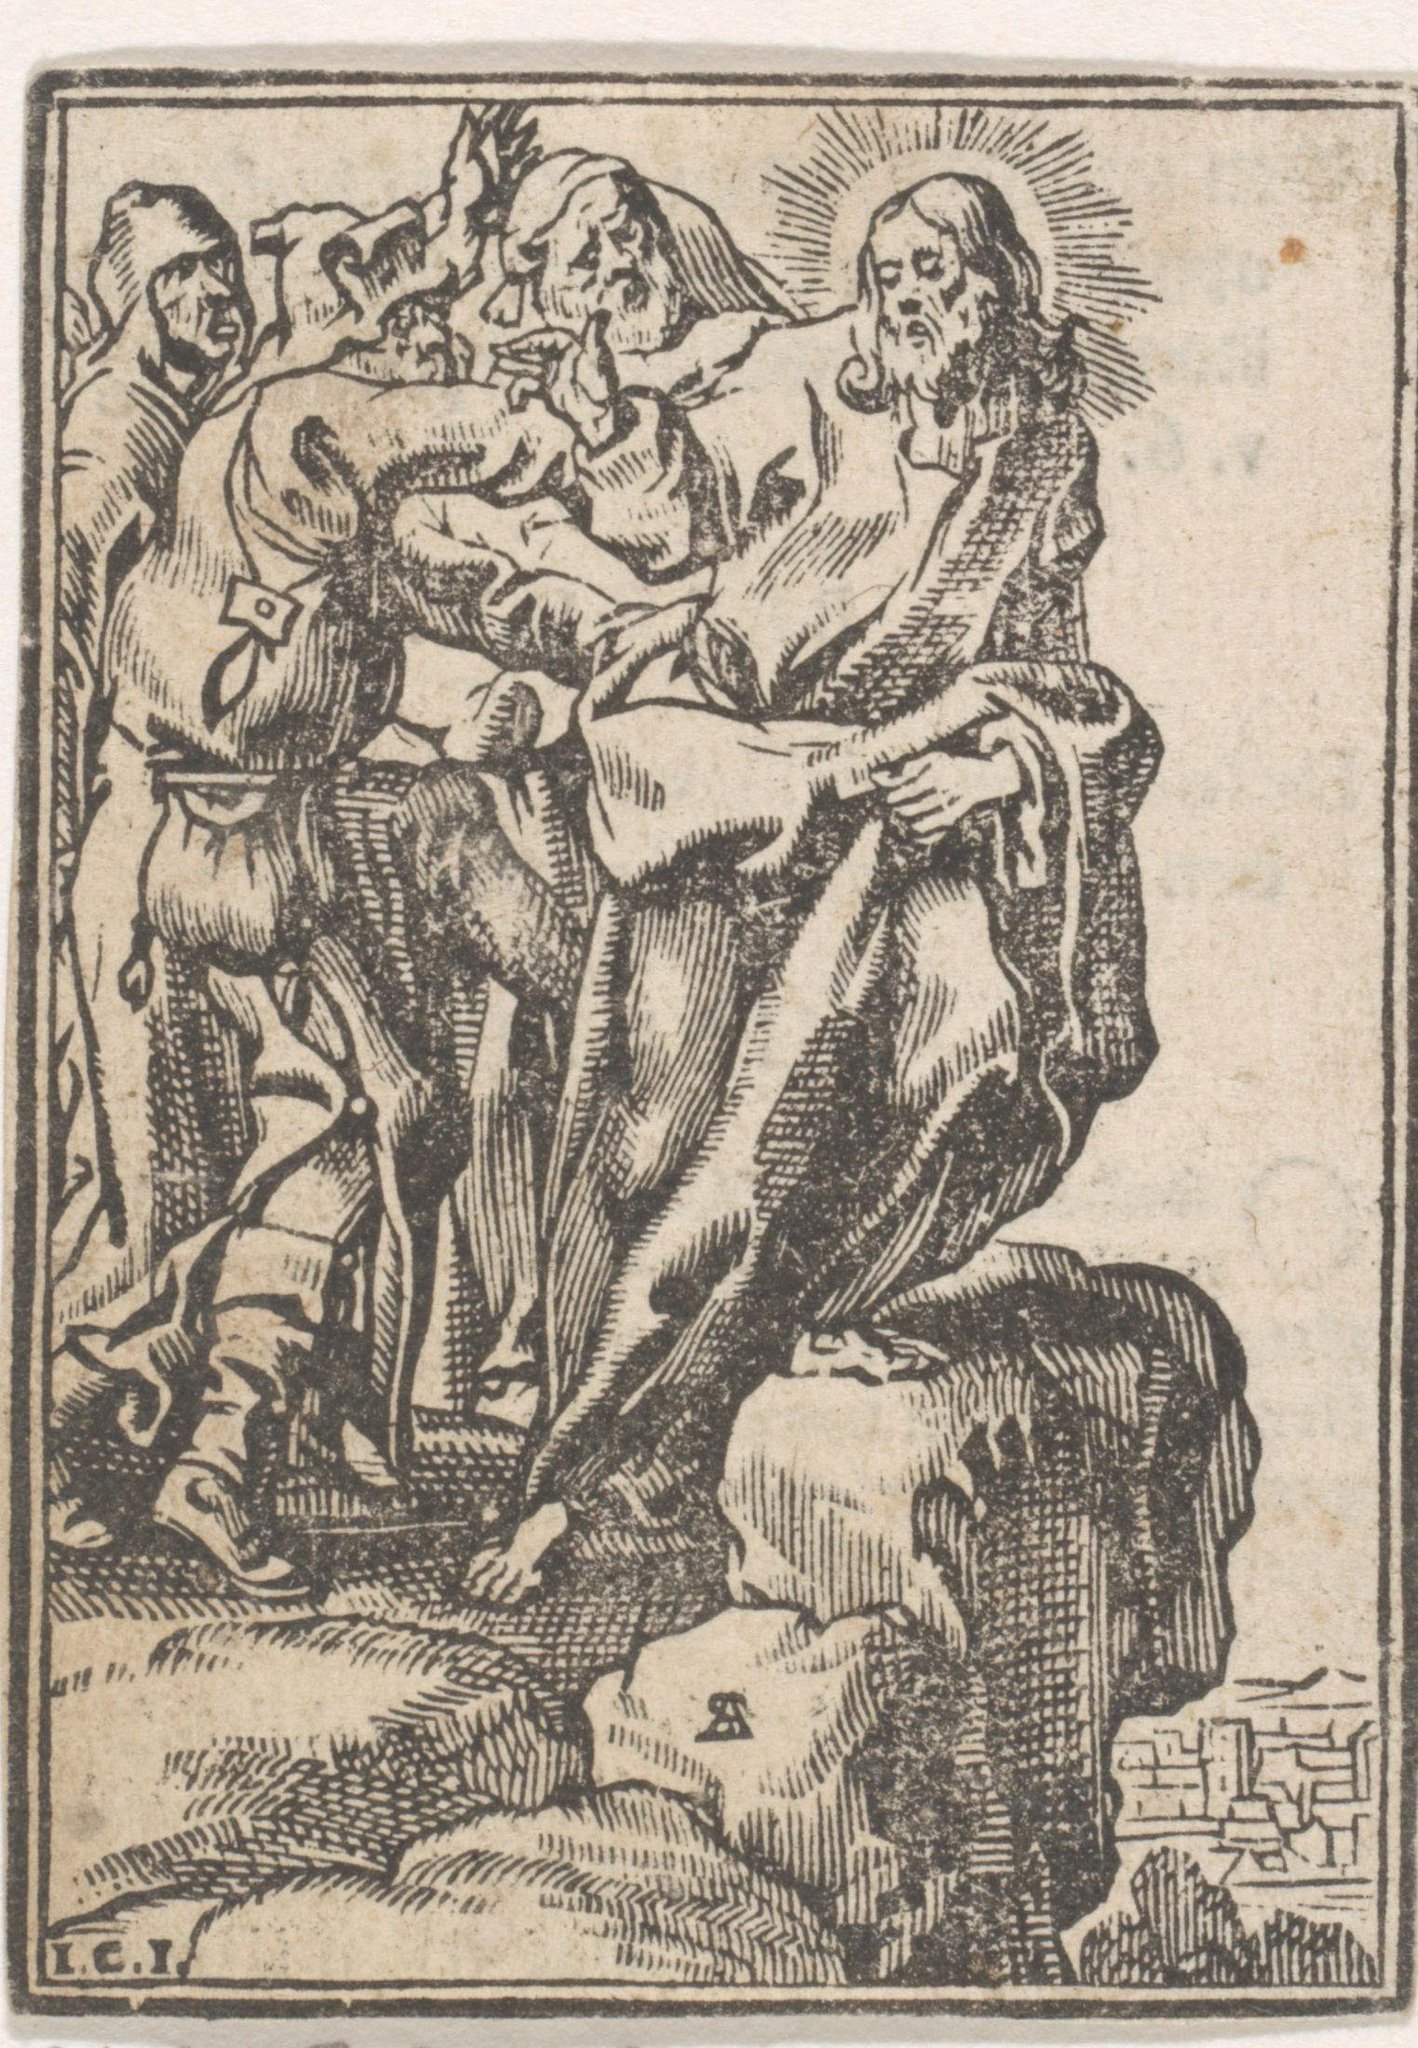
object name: print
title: Inwoners van Nazareth verdrijven Christus uit de stad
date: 1649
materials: paper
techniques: letterpress printing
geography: antwerp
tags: rejection of christ's preaching in nazareth: 'a prophet is not without honour except in his own country ...' (matthew 13:54-57; mark 6:1-4; luke 4:22-24; john 4:44)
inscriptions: collector's mark: Lugt 698, collector's mark: Lugt 240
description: De inwoners van Nazareth verdrijven Christus de stad uit, naar de rand van de berg waarop hun stad gebouwd was, om hem in de afgrond te storten.